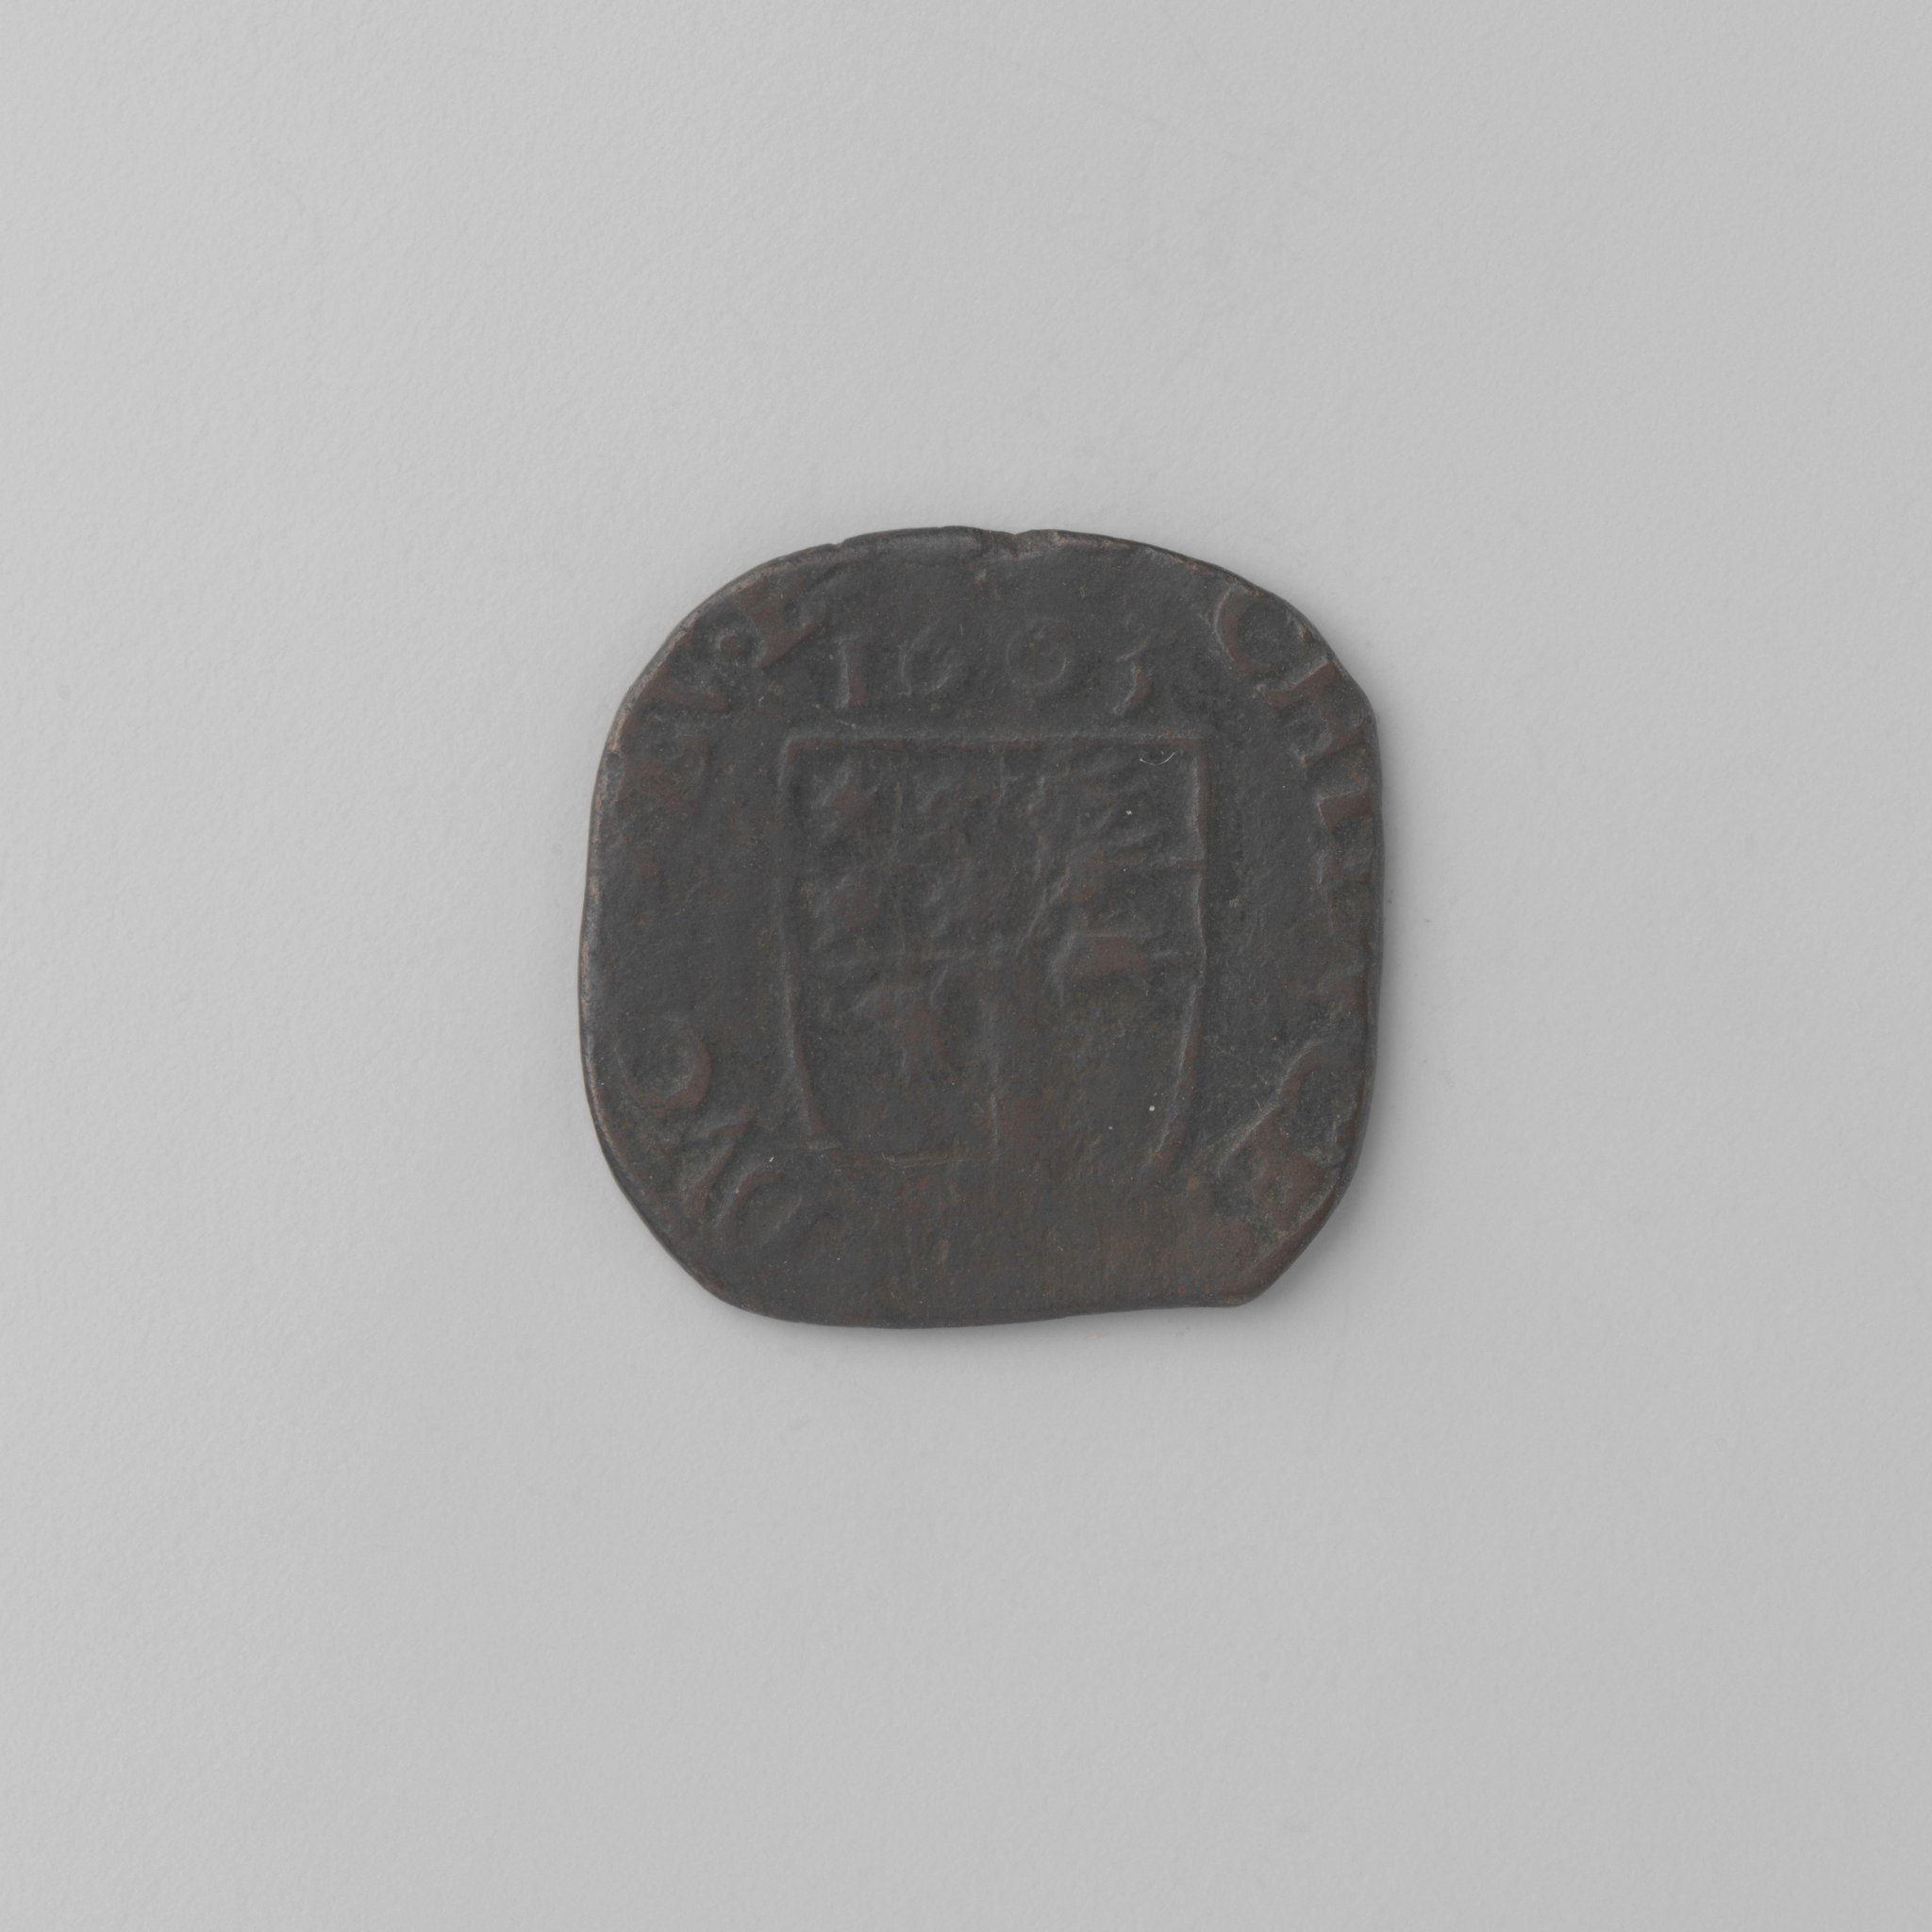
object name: coin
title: Duit van de aartshertogen Albert en Isabella, hertogen van Brabant, 1603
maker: hertog van brabant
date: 1603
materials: copper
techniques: striking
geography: den bosch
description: Koperen munt. Voorzijde: gekroond wapenschild. Keerzijde: wapenschild van de stad 's-Hertogenbosch, daarboven jaartal. Munt gesnoeid tot vierkant.